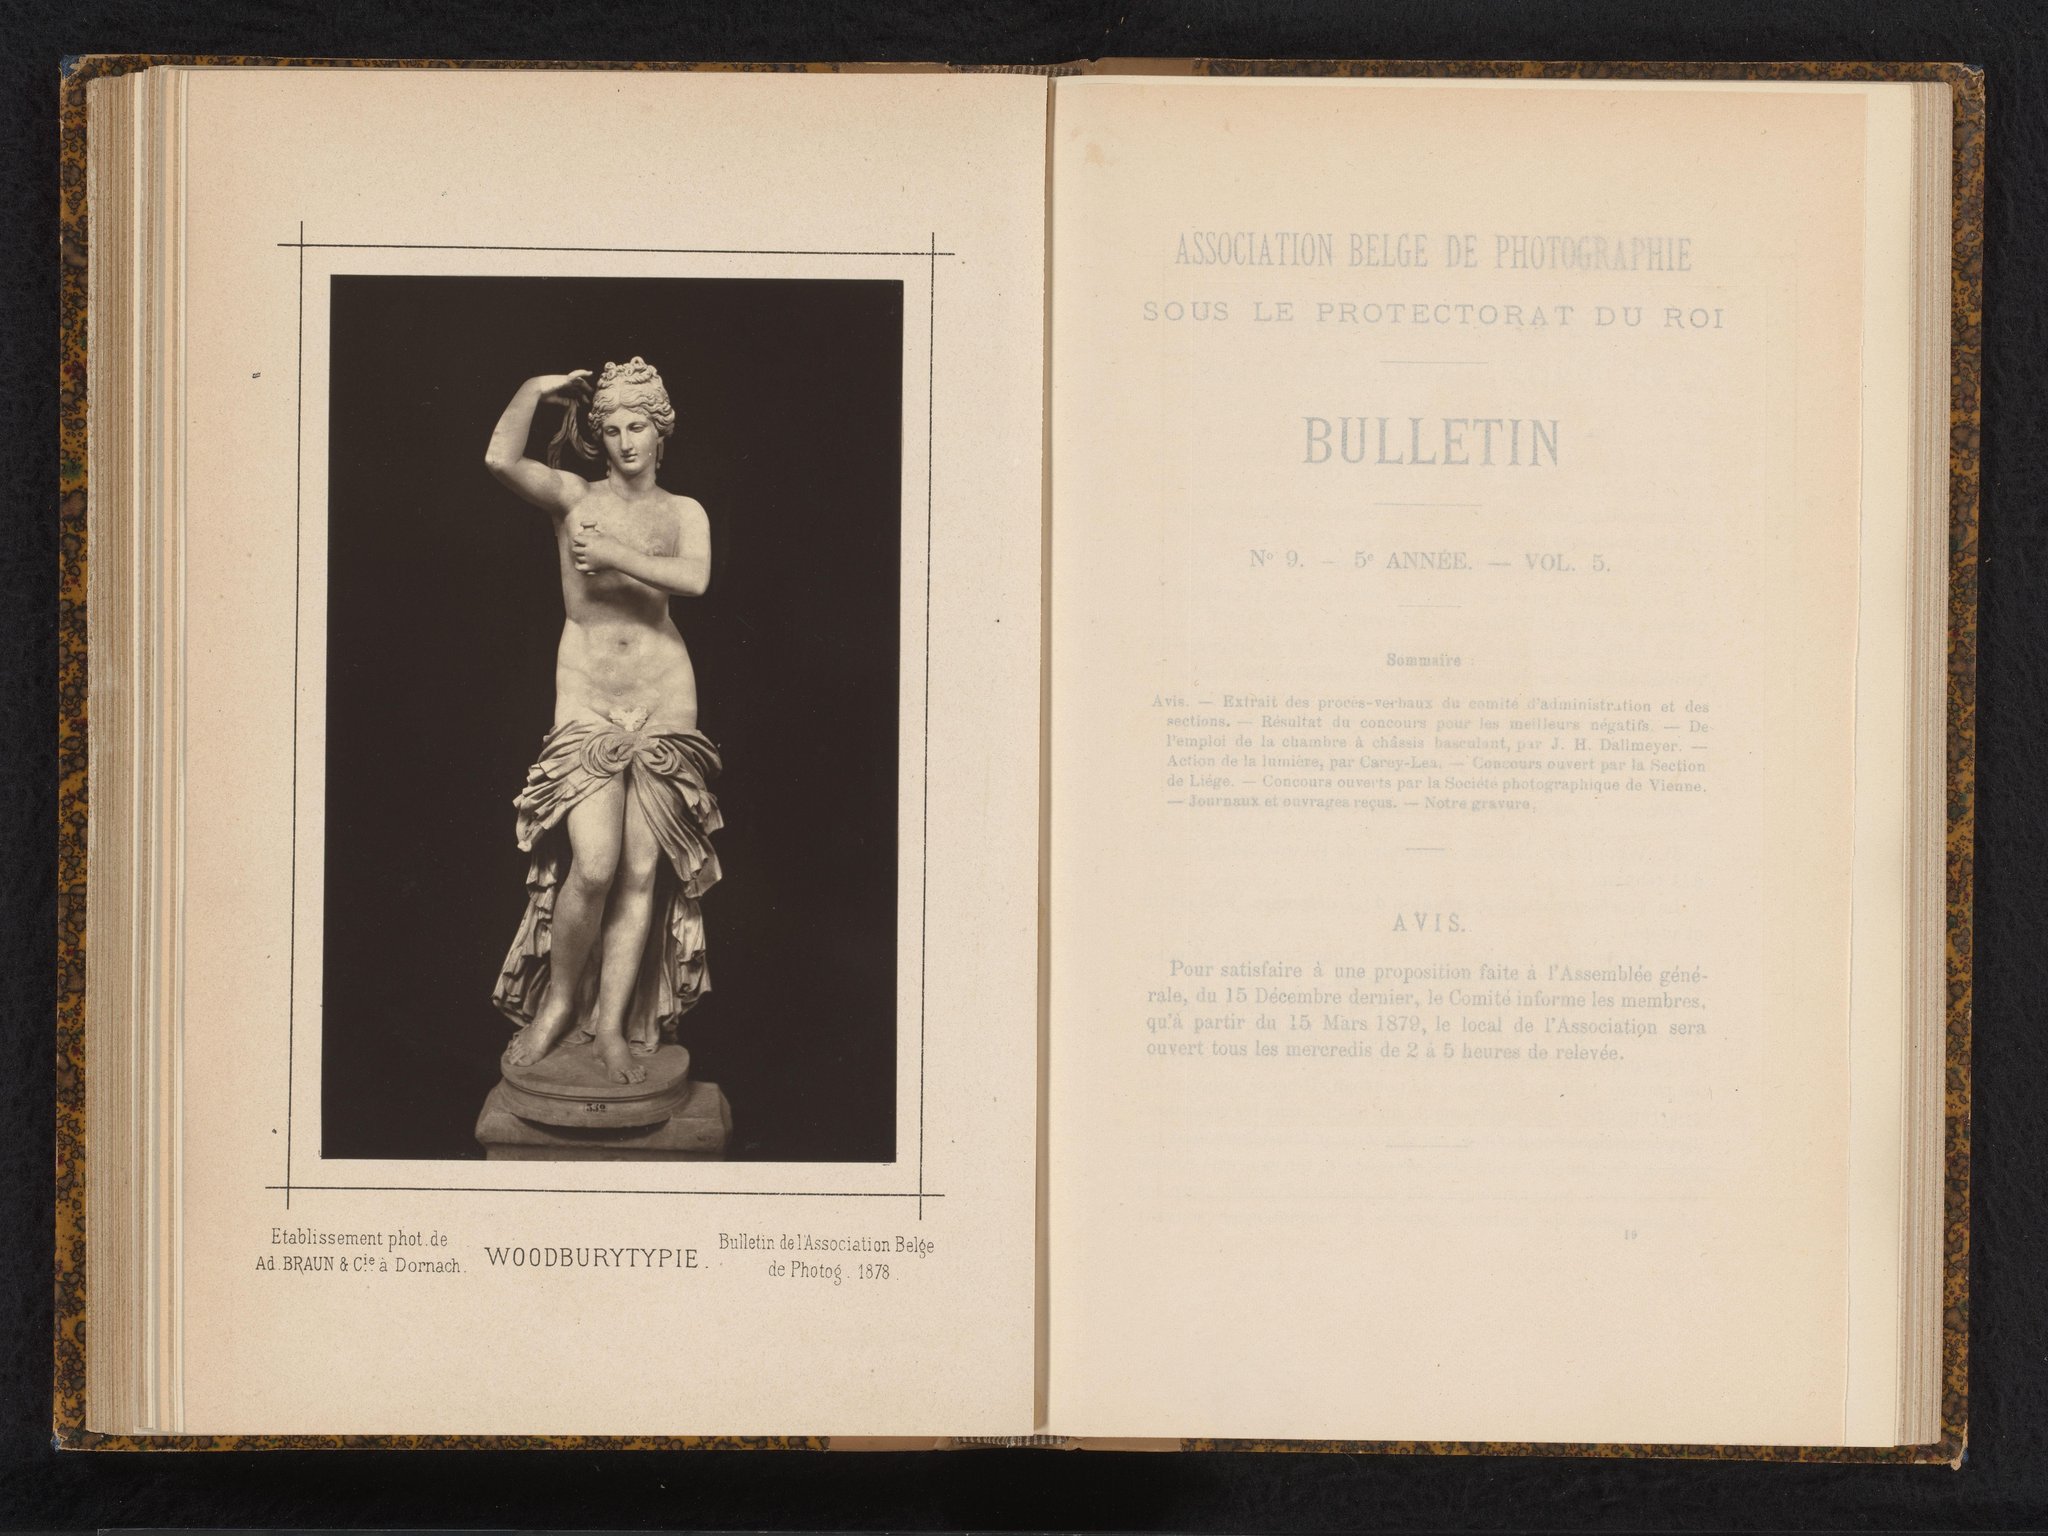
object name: photomechanical print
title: Reproductie van een prent naar een schilderij van Venus door Titiaan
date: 1878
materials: paper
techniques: photograph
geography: dresden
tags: aggressive, unfriendly activities and relationships of minerva